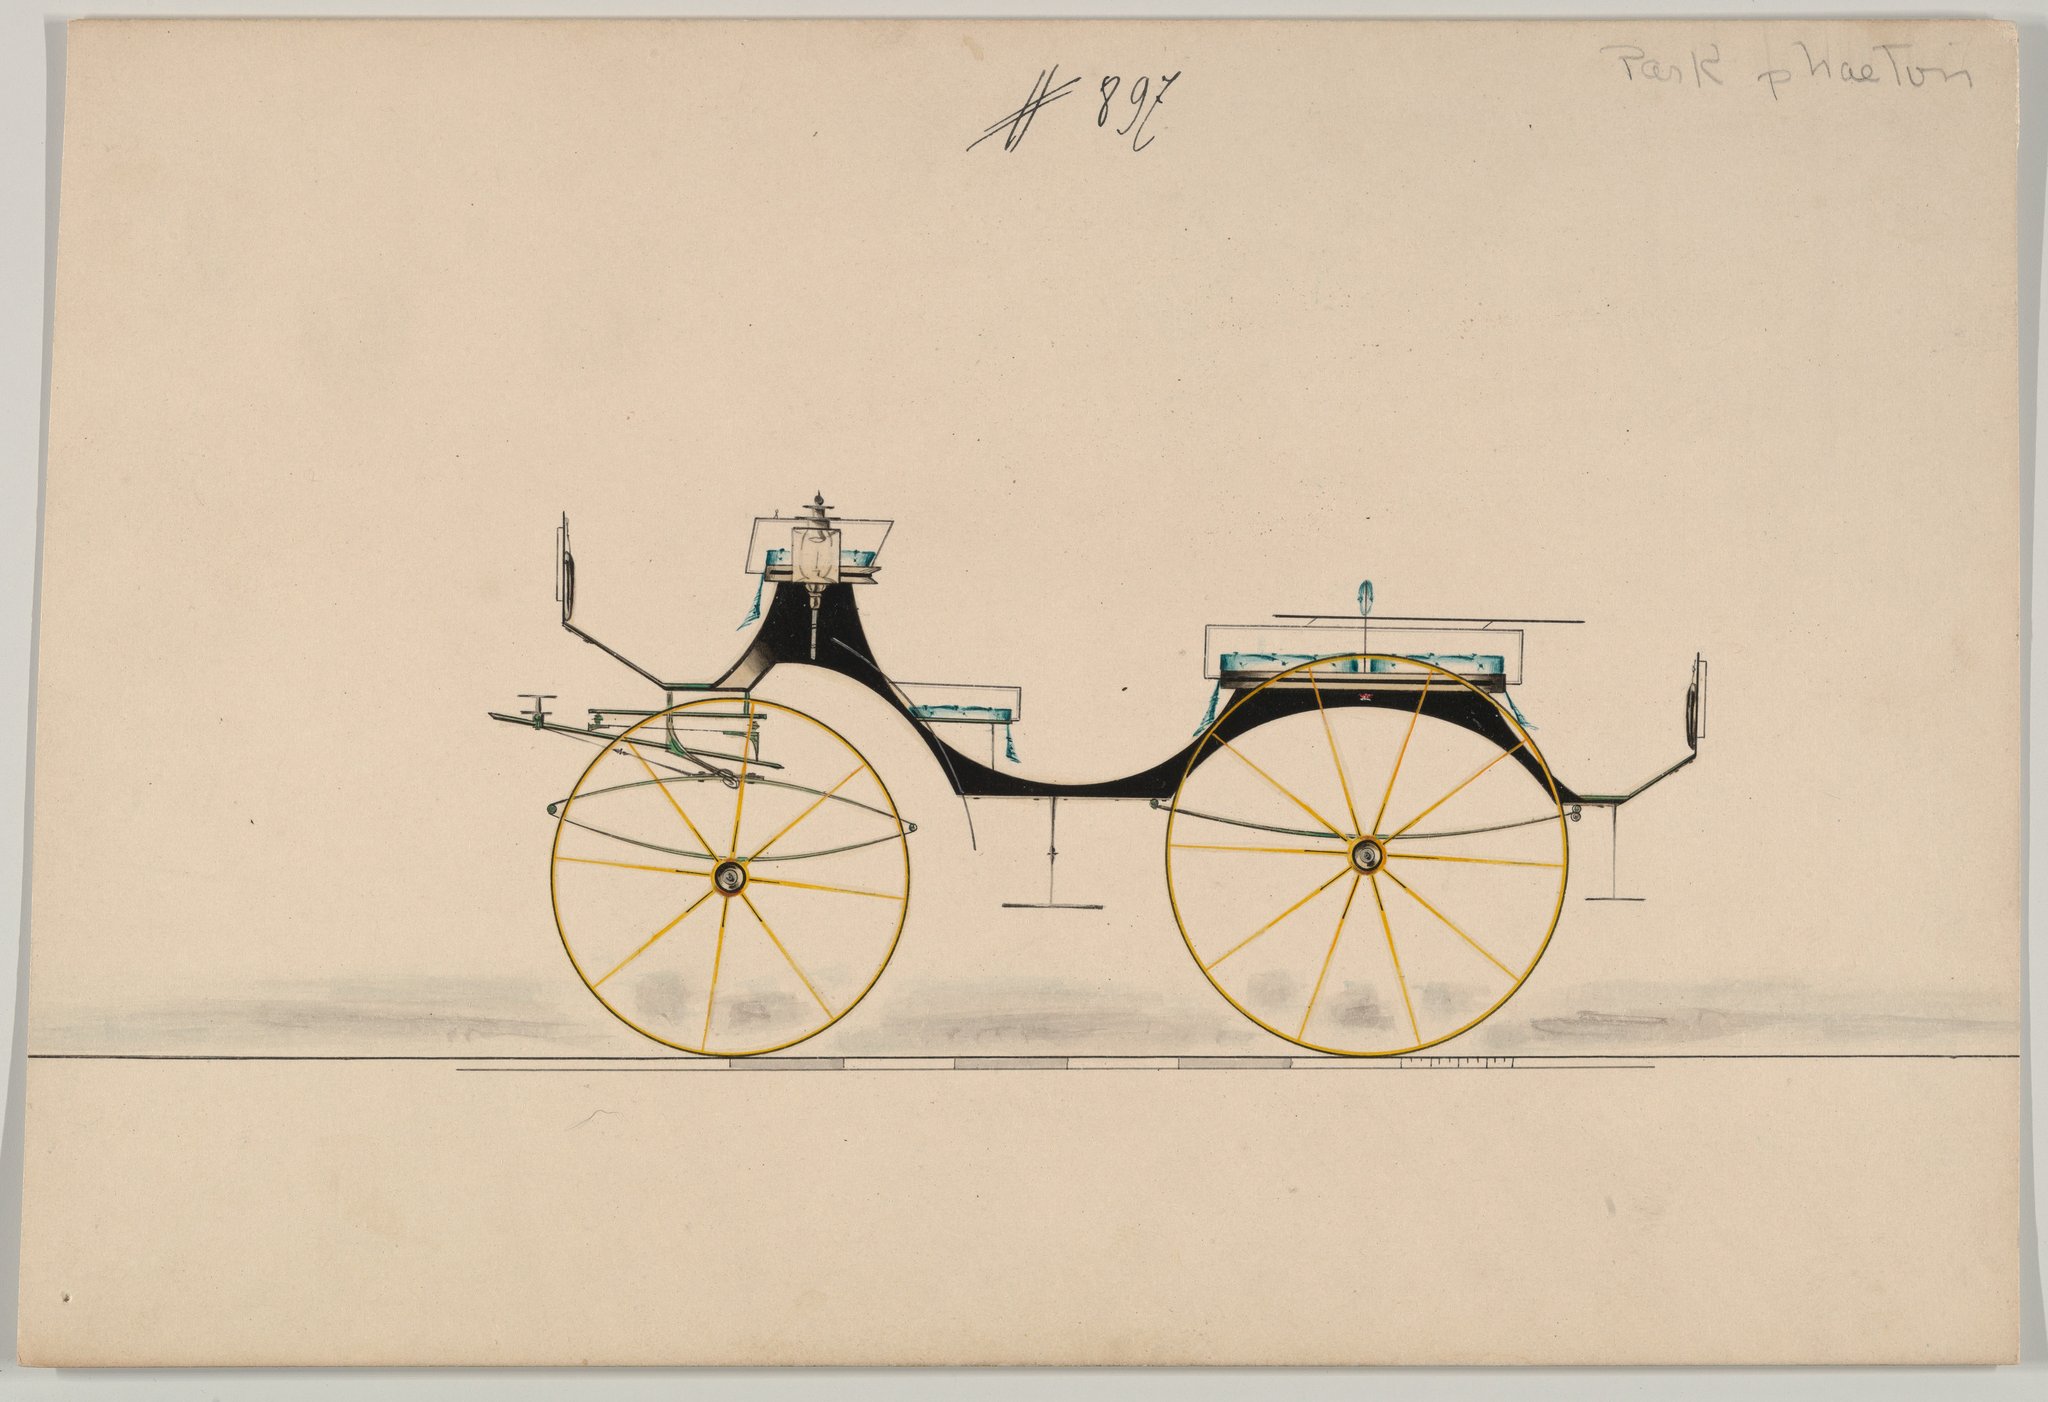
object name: drawing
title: Design for Phaeton, no. 897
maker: brewster & co.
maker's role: manufacturer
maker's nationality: american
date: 1850-1870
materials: ink, watercolor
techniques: pen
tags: carriages